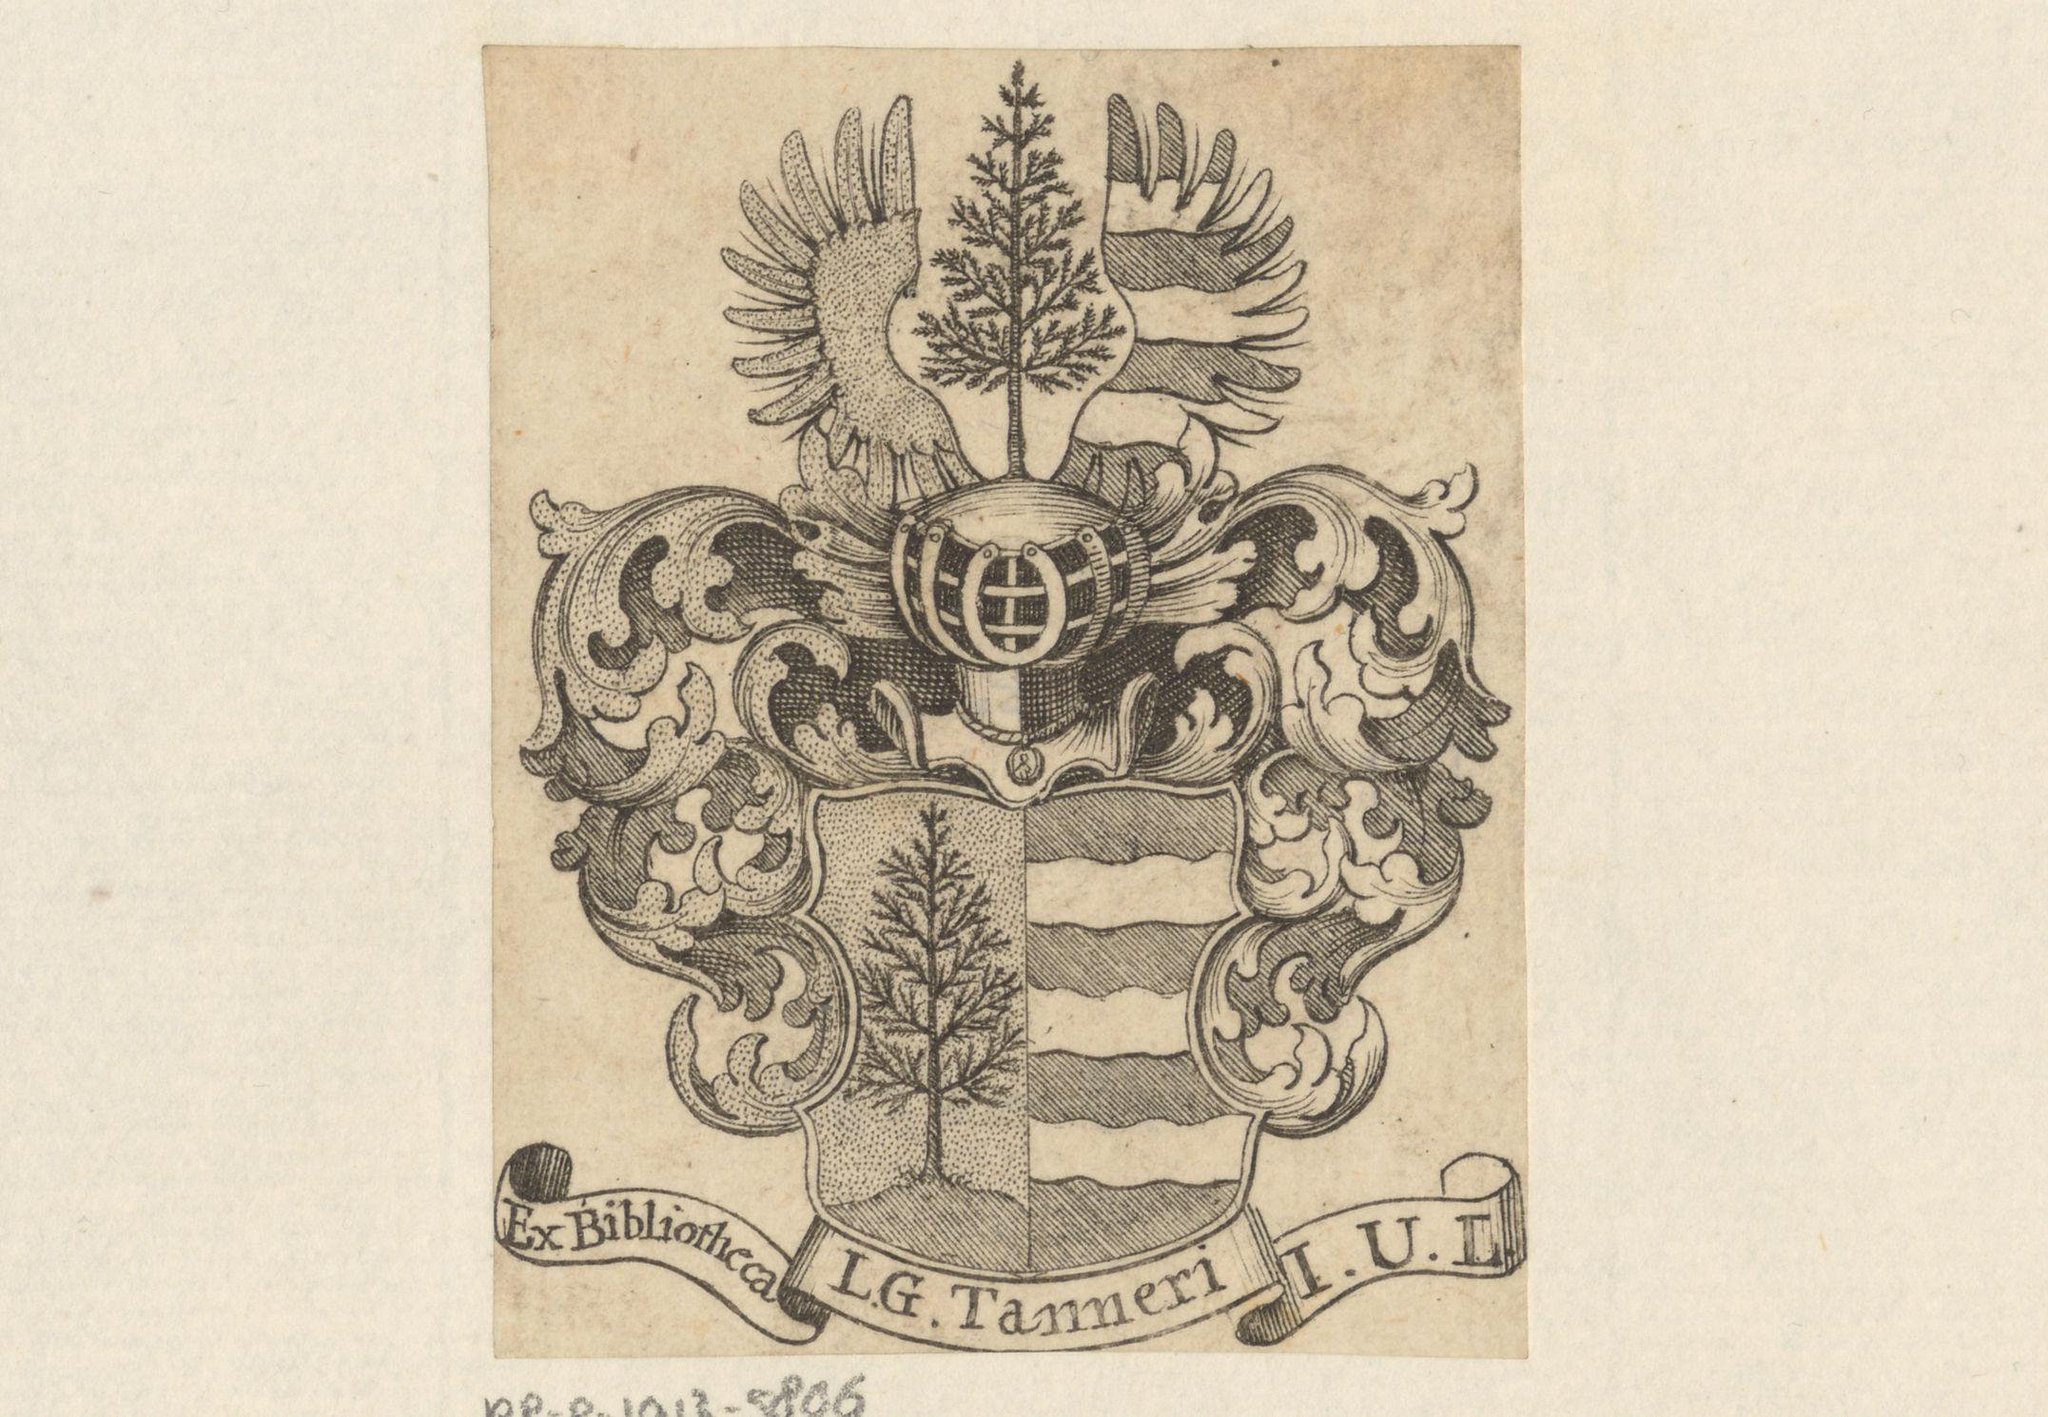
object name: bookplate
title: L.G. Tanneri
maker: Anonymous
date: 1700-1800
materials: paper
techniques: engraving, etching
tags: trees, armorial bearing, heraldry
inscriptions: collector's mark: Lugt 2760, collector's mark: Lugt 2233